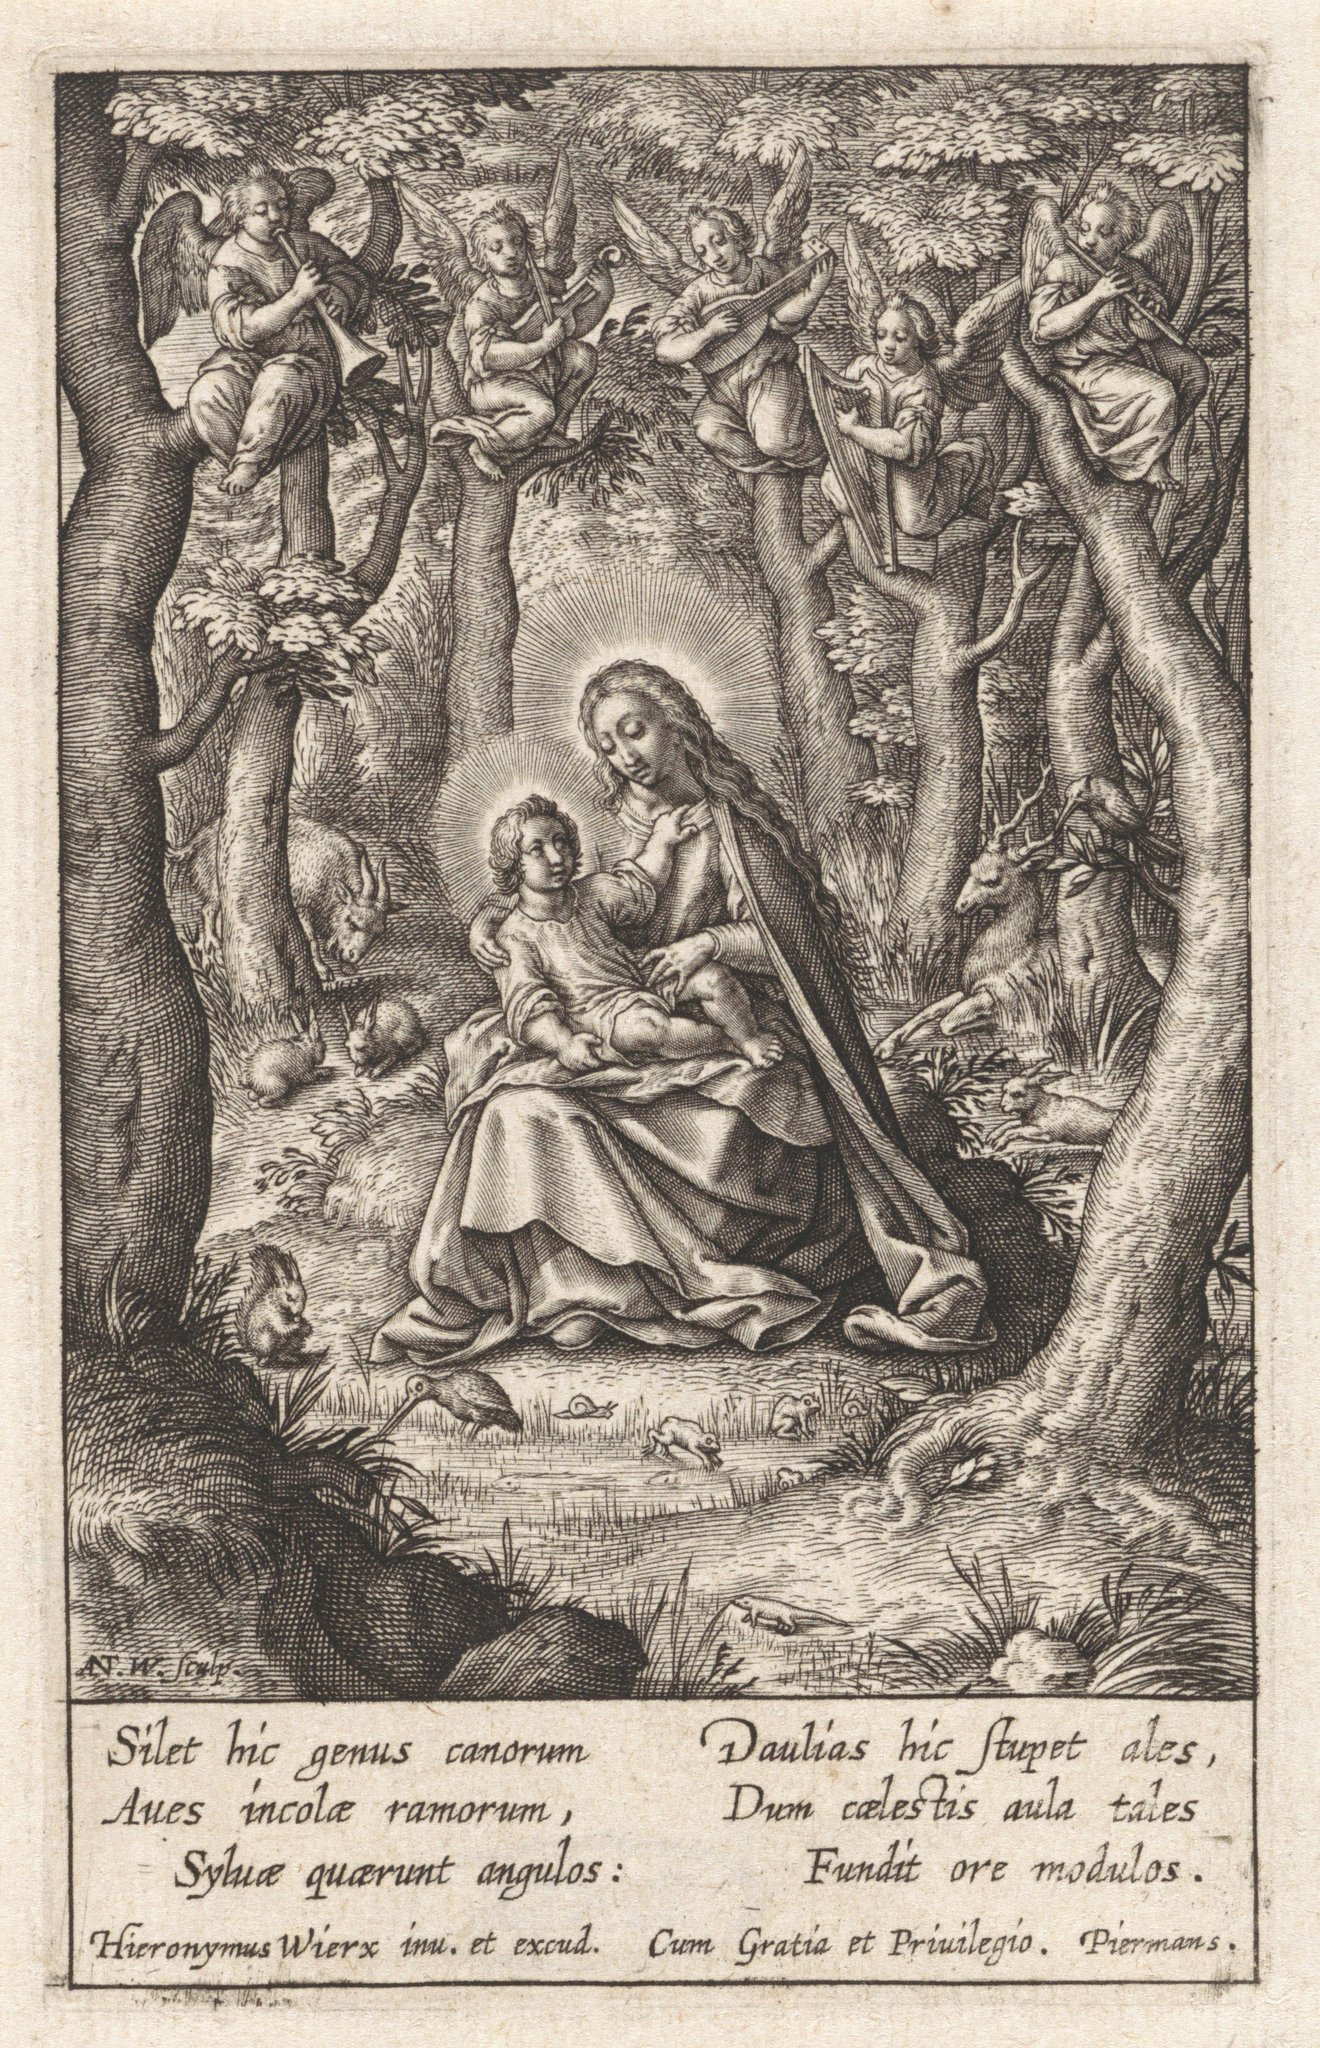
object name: print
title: Rest on the Flight into Egypt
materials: paper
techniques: engraving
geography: antwerp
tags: rest on the flight into egypt (+ angel(s))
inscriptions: collector's mark: Lugt 2228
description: Maria zit met het Christuskind op schoot op een open plek in het bos. Ze worden omringd door verschillende dieren. Op de takken in de bomen rond hen zitten musicerende engelen. In de marge een zesregelig onderschrift, in twee kolommen, in het Latijn.